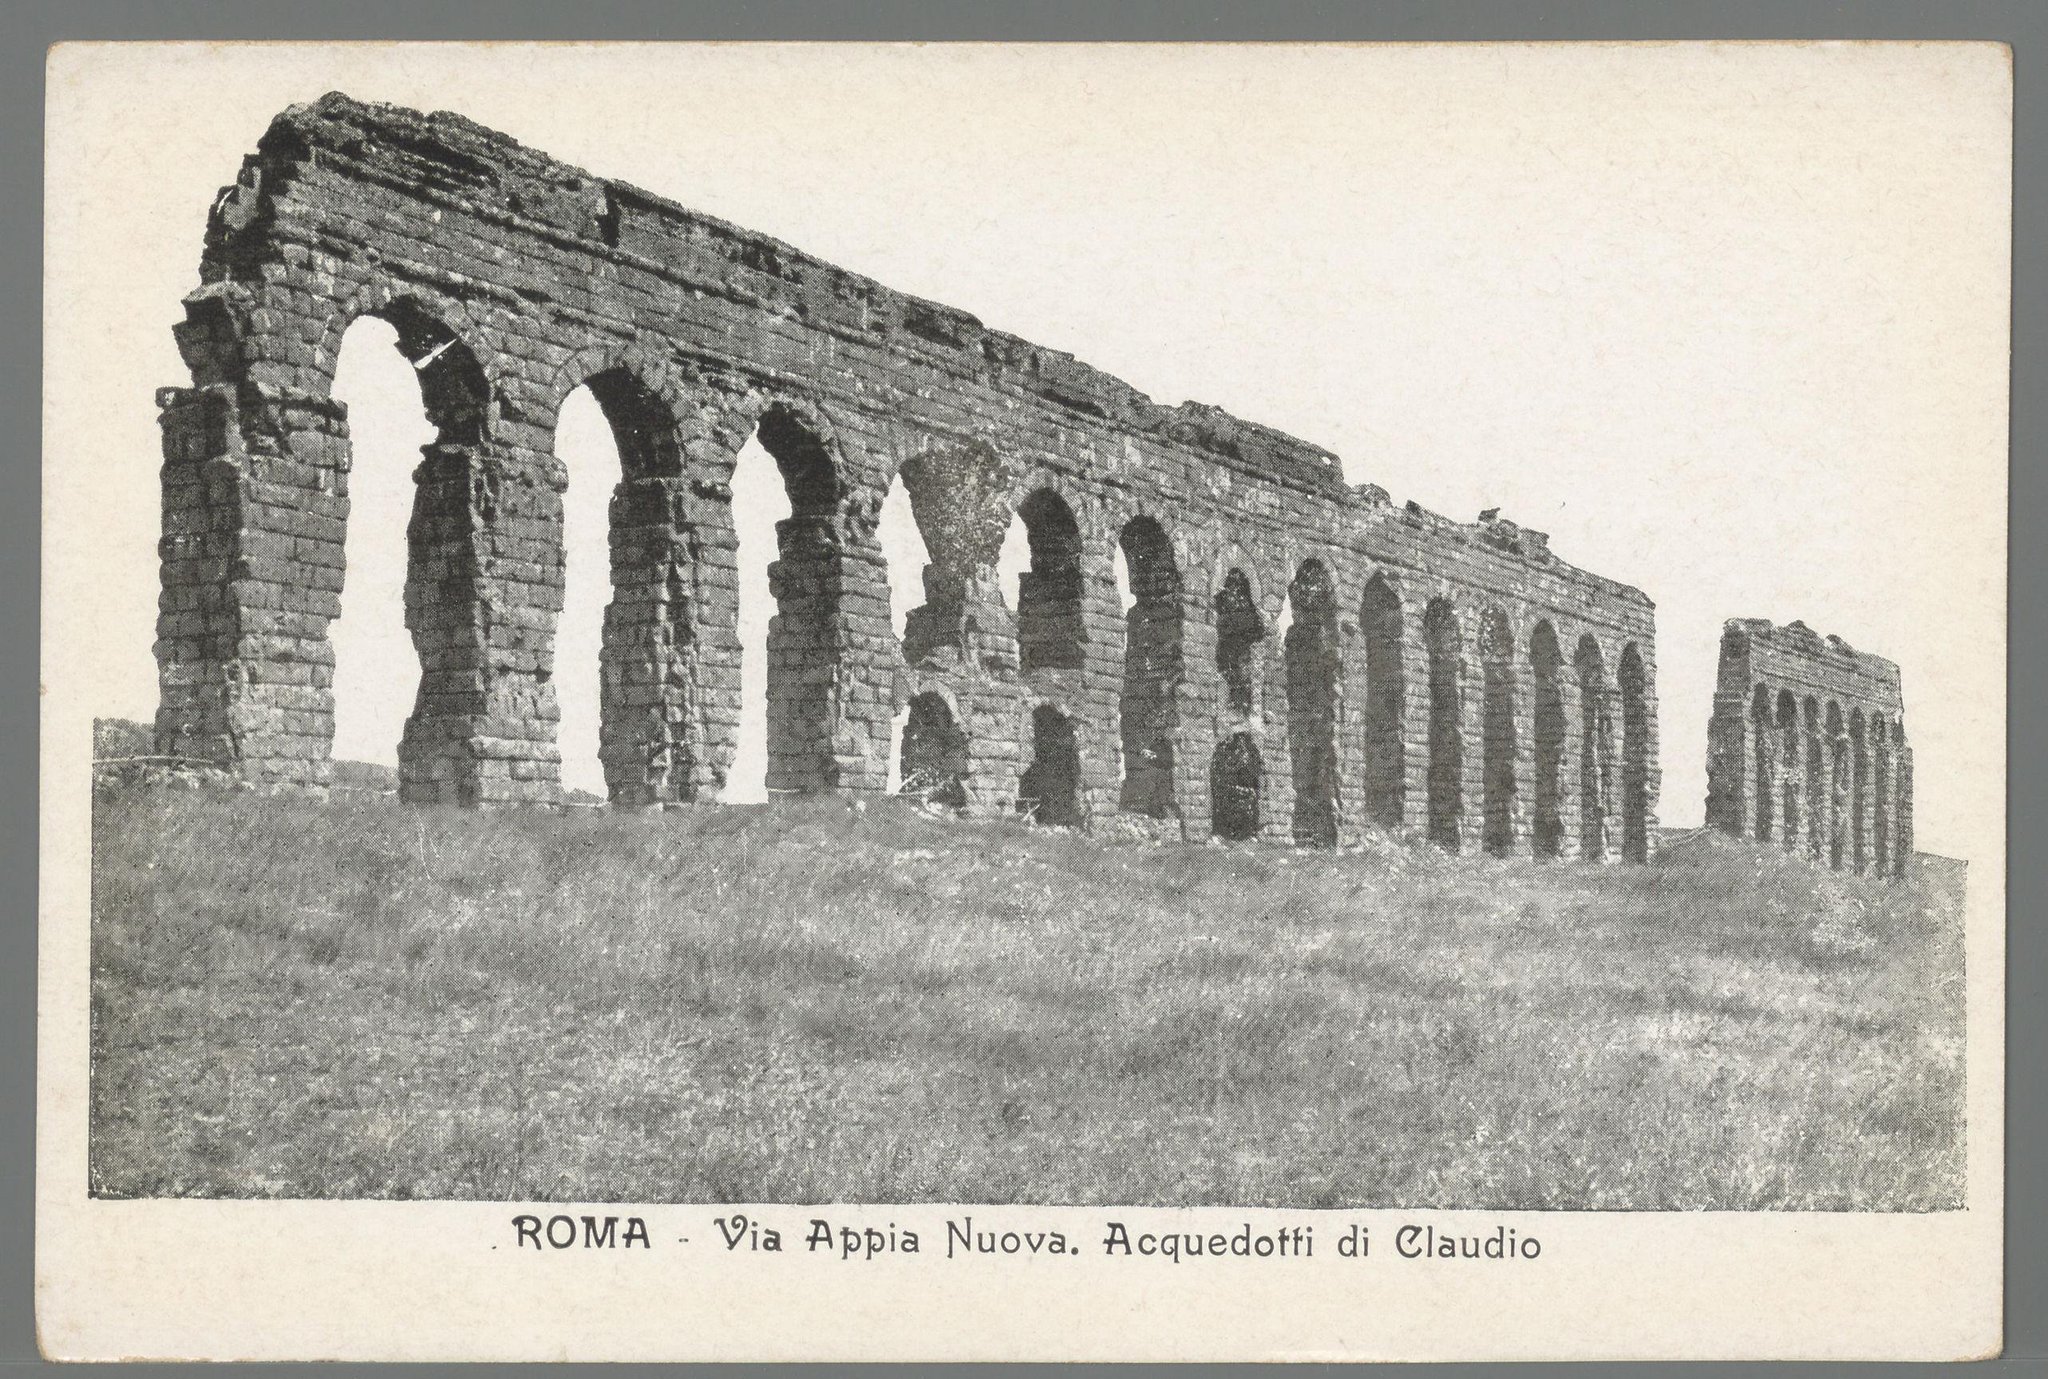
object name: photomechanical print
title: Roma. Via Appia Nuova. Acquedotti di Claudio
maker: Anonymous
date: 1906-1930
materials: cardboard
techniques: autotype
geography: rome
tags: landscape with bridge, viaduct or aqueduct